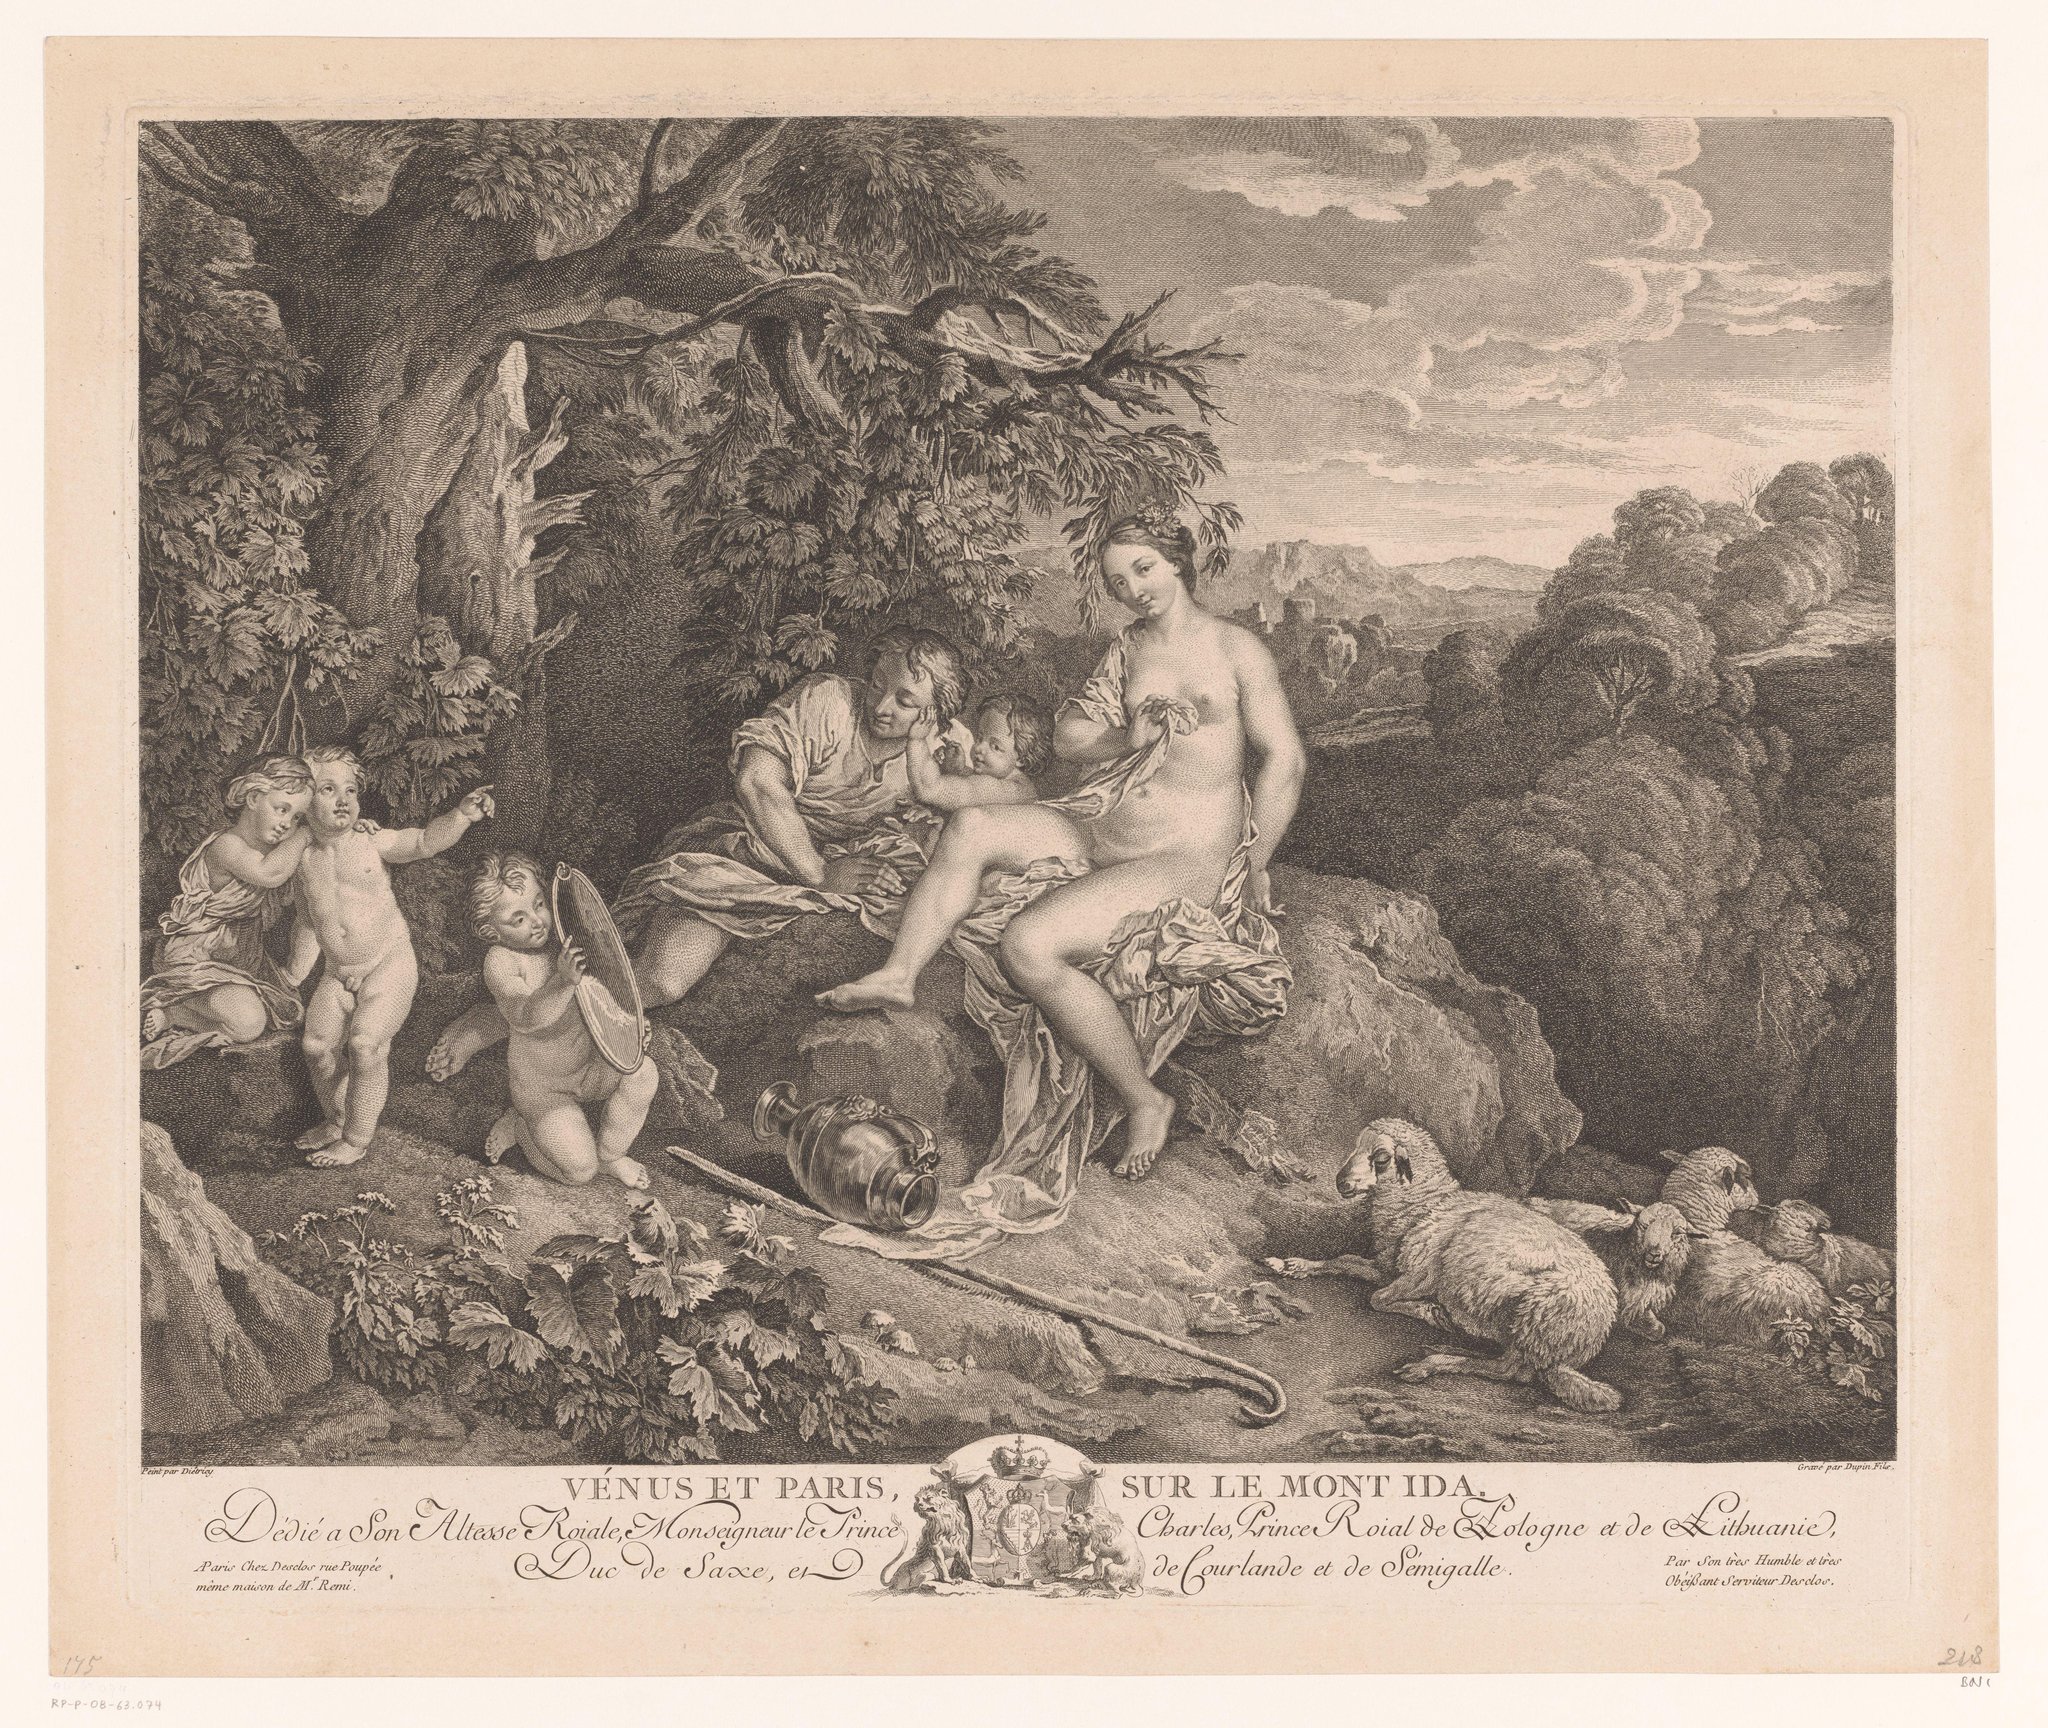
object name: print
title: Vénus et Paris, sur le mont Ida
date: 1703-1770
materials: paper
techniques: engraving, etching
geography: paris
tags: paris is exposed on mount ida, (story of) venus (aphrodite), armorial bearing, heraldry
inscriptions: collector's mark: Lugt 2228